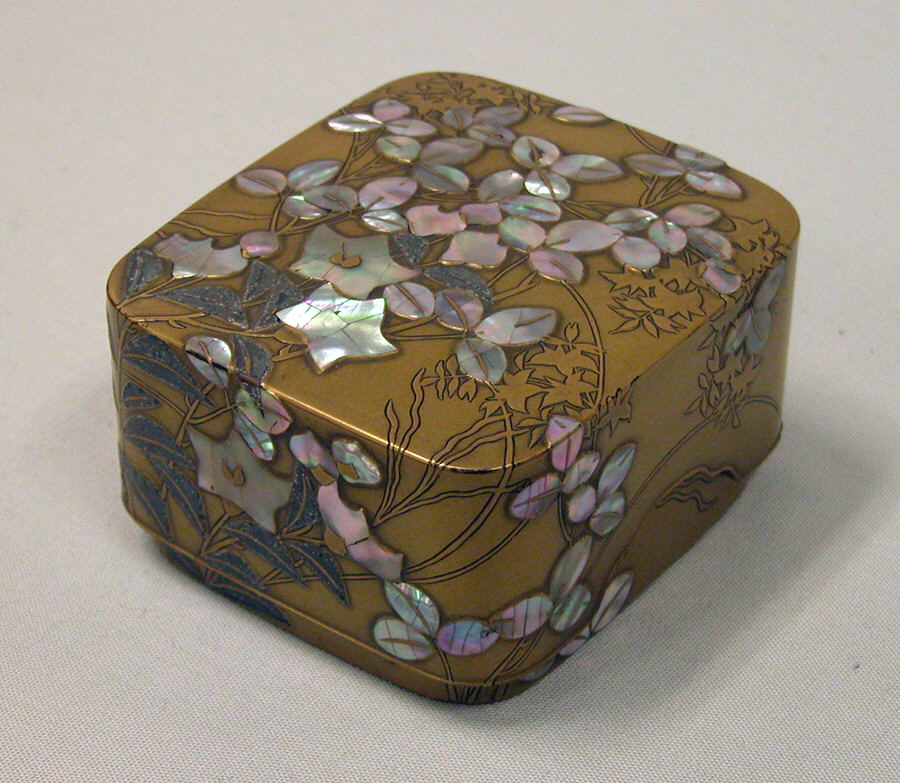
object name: box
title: Box with Design of Bellflower and Bush Clover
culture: japanese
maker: ogata kōrin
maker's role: artist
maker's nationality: japanese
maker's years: 1658-1716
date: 1851-1900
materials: gold, gold leaf, mother of pearl, tin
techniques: hiramakie, inlay, maki-e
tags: flowers,leaves